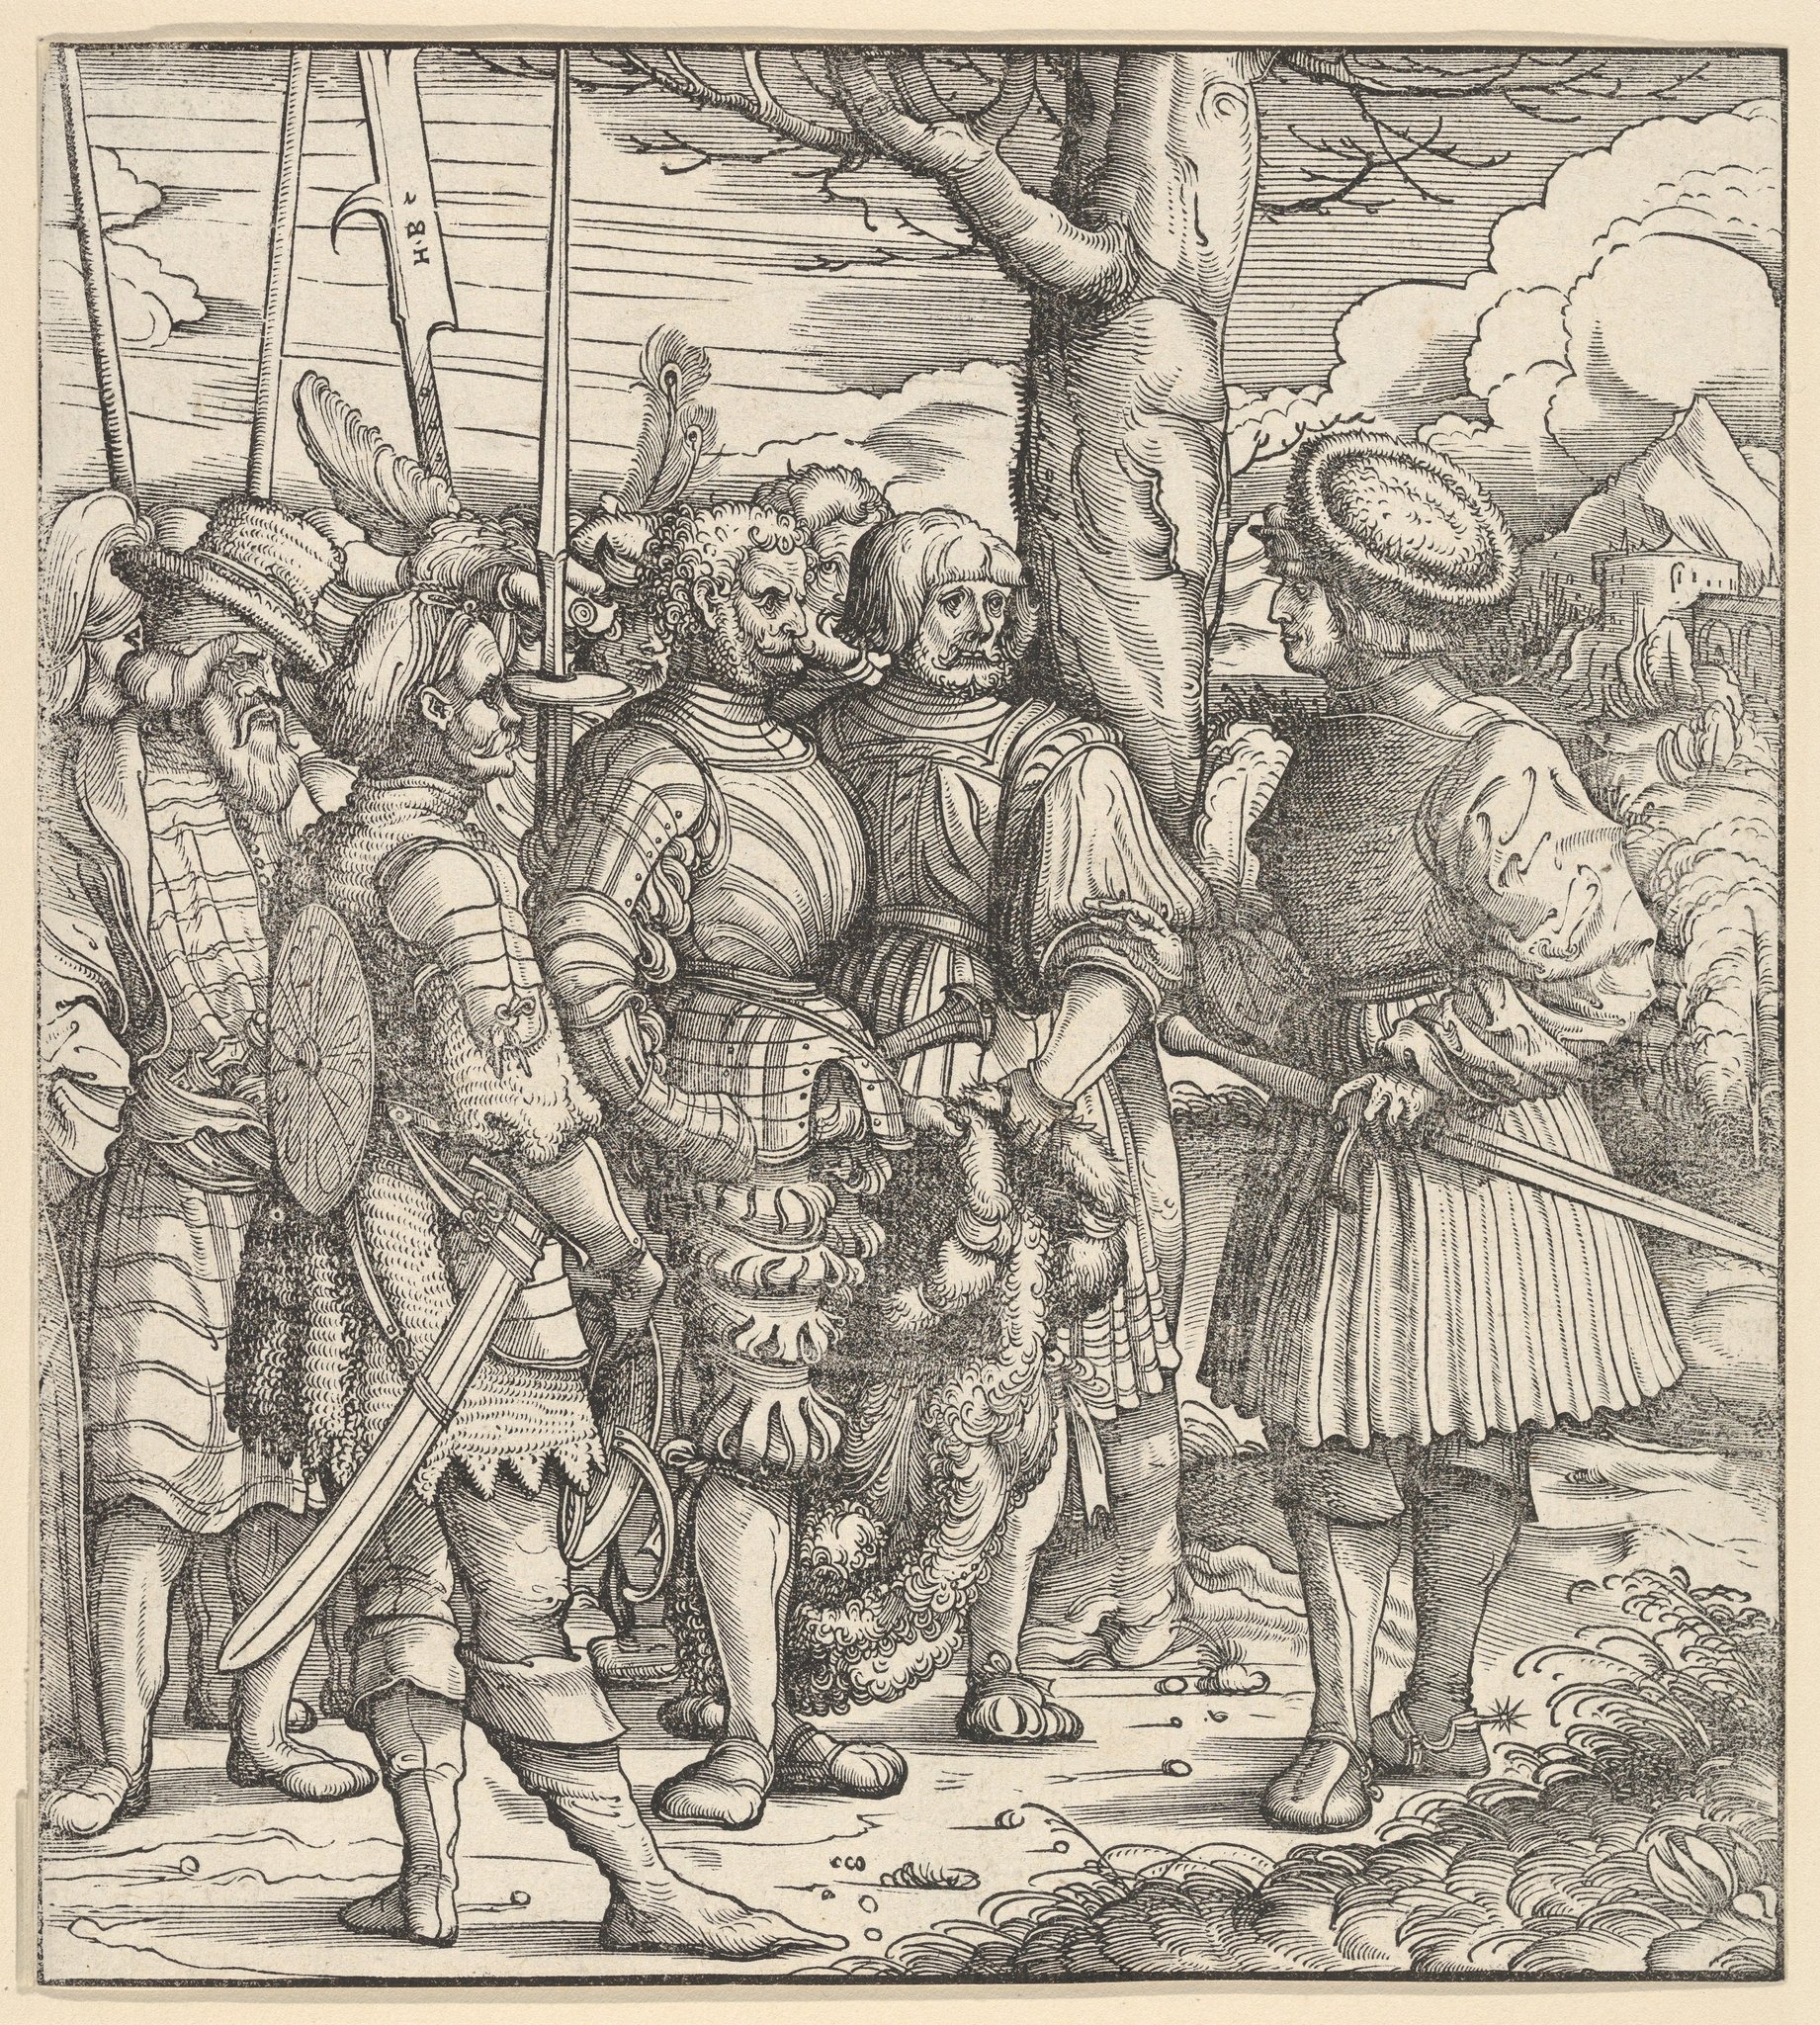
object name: print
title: The Skill of the White King Dealing with Different Nations in Wartime, from "Der Weisskunig"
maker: hans burgkmair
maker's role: artist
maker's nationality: german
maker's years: 1473-1531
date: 1501-1600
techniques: woodcut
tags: soldiers,swords,kings